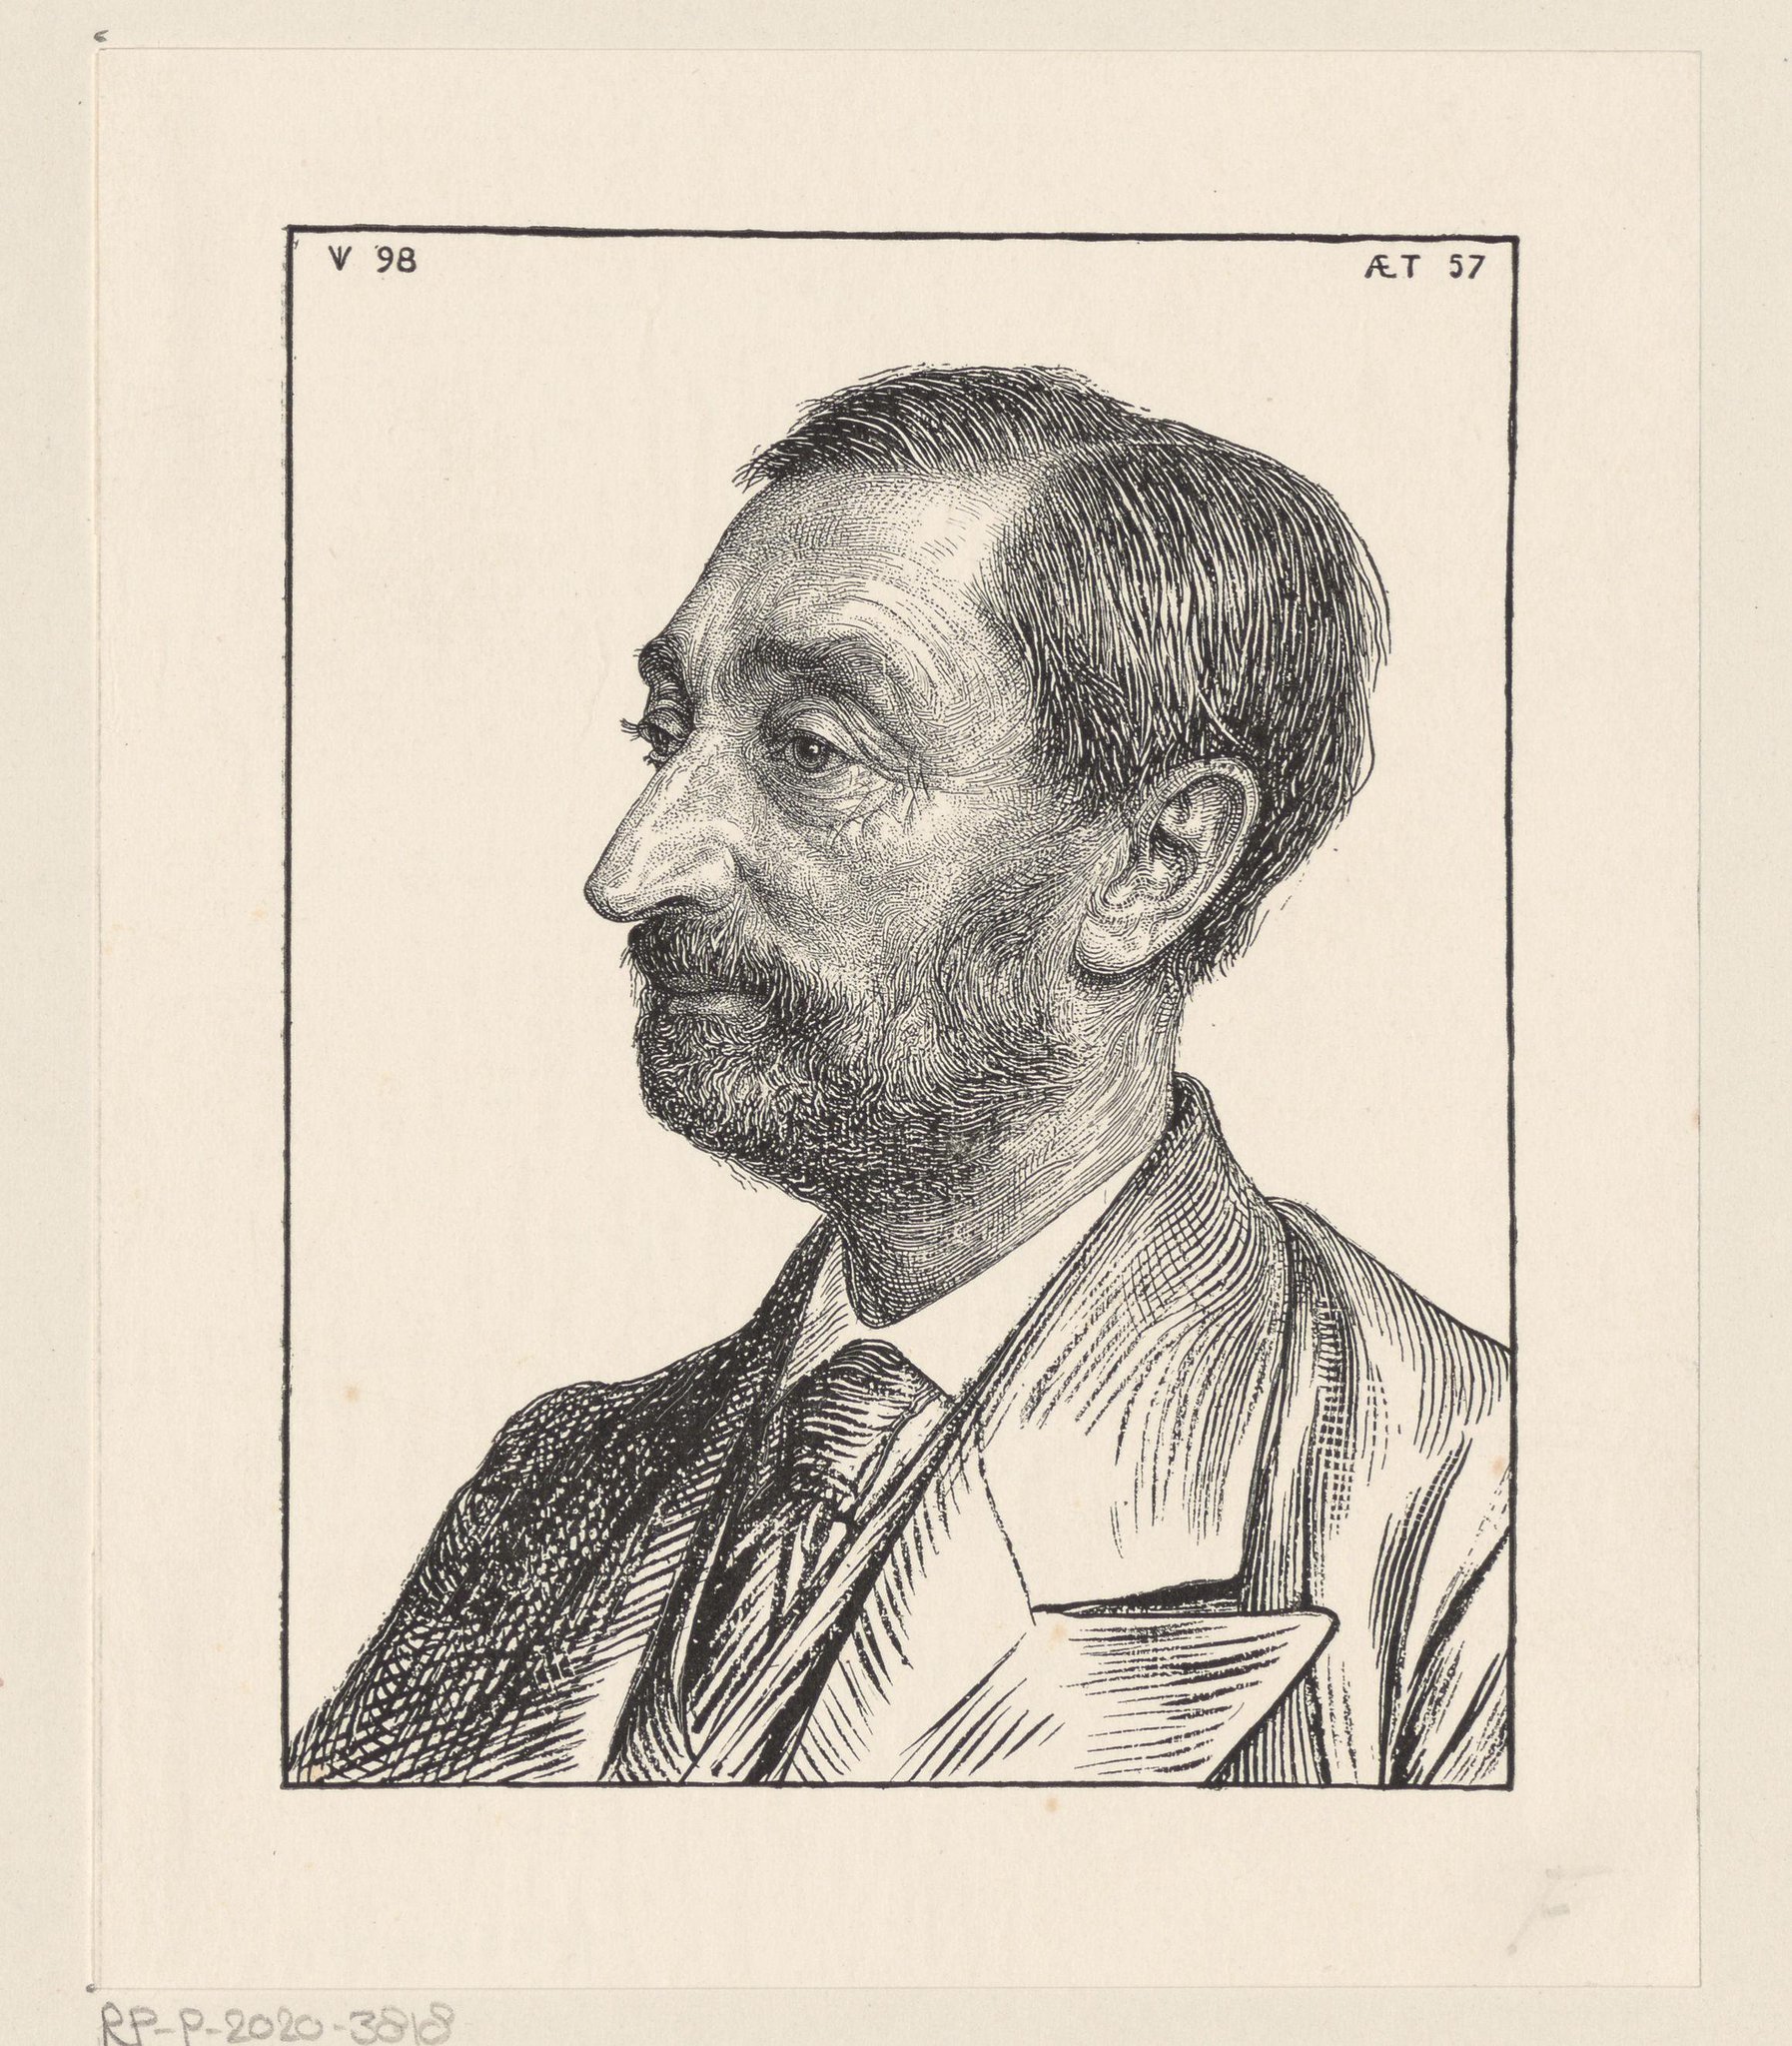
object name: print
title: Portret van Pieter Jacob Cosijn op 57-jarige leeftijd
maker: jan veth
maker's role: designer, draughtsman, painter, print maker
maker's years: 1864-1925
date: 1898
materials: paper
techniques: engraving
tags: leiden, historical persons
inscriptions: date